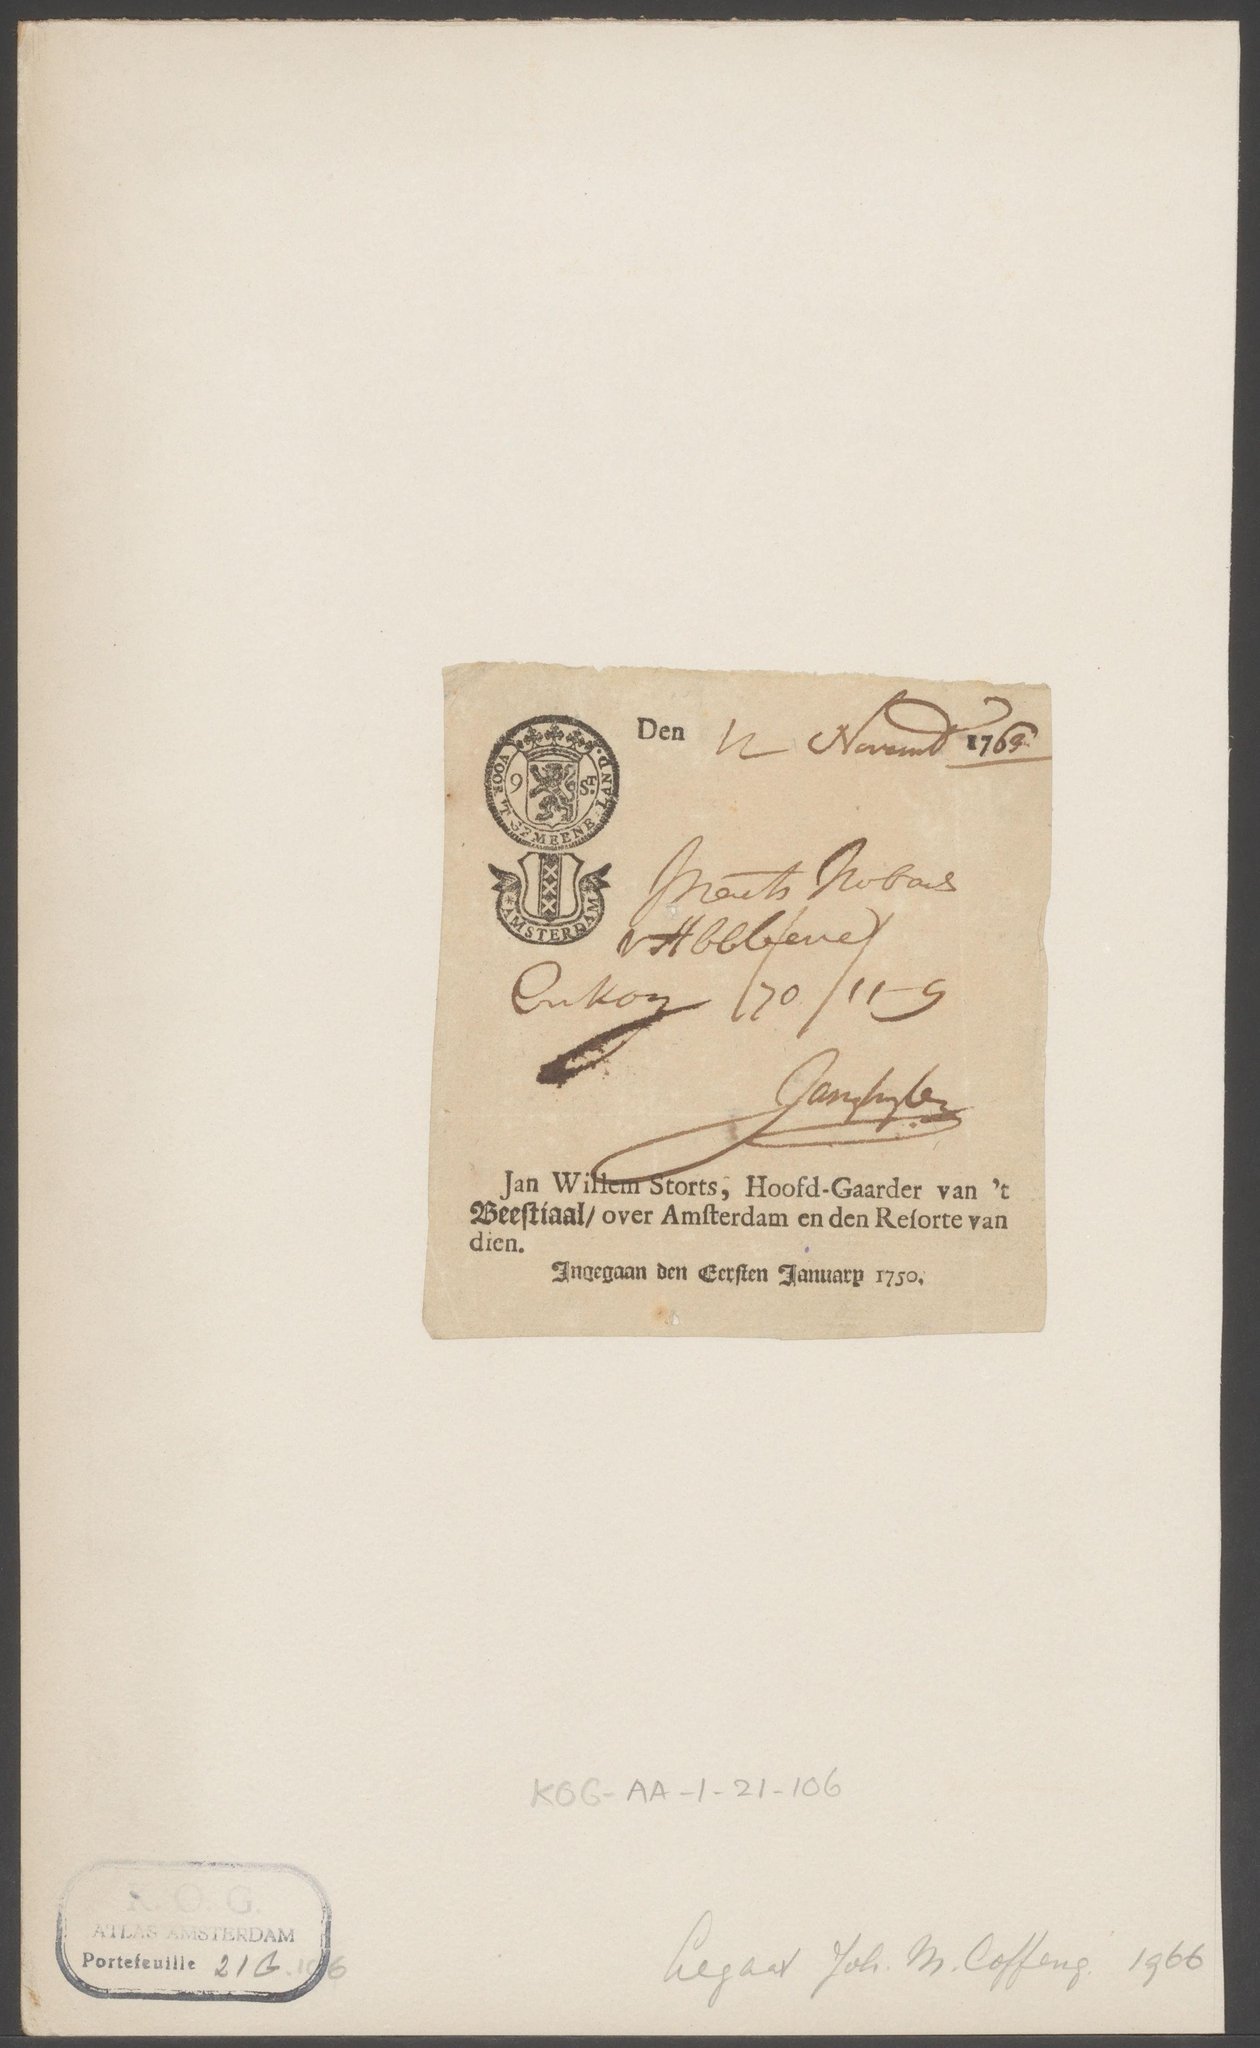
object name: document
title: Verklaring omtrent accijnzen slachtvlees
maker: jan willem storts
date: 1764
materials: ink, paper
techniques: letterpress printing, pen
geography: amsterdam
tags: tax collection, tax payment, amsterdam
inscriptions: collector's mark: Lugt 1641b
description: Onderwerpsrubriek binnen de Atlas Amsterdam: Belastingen.